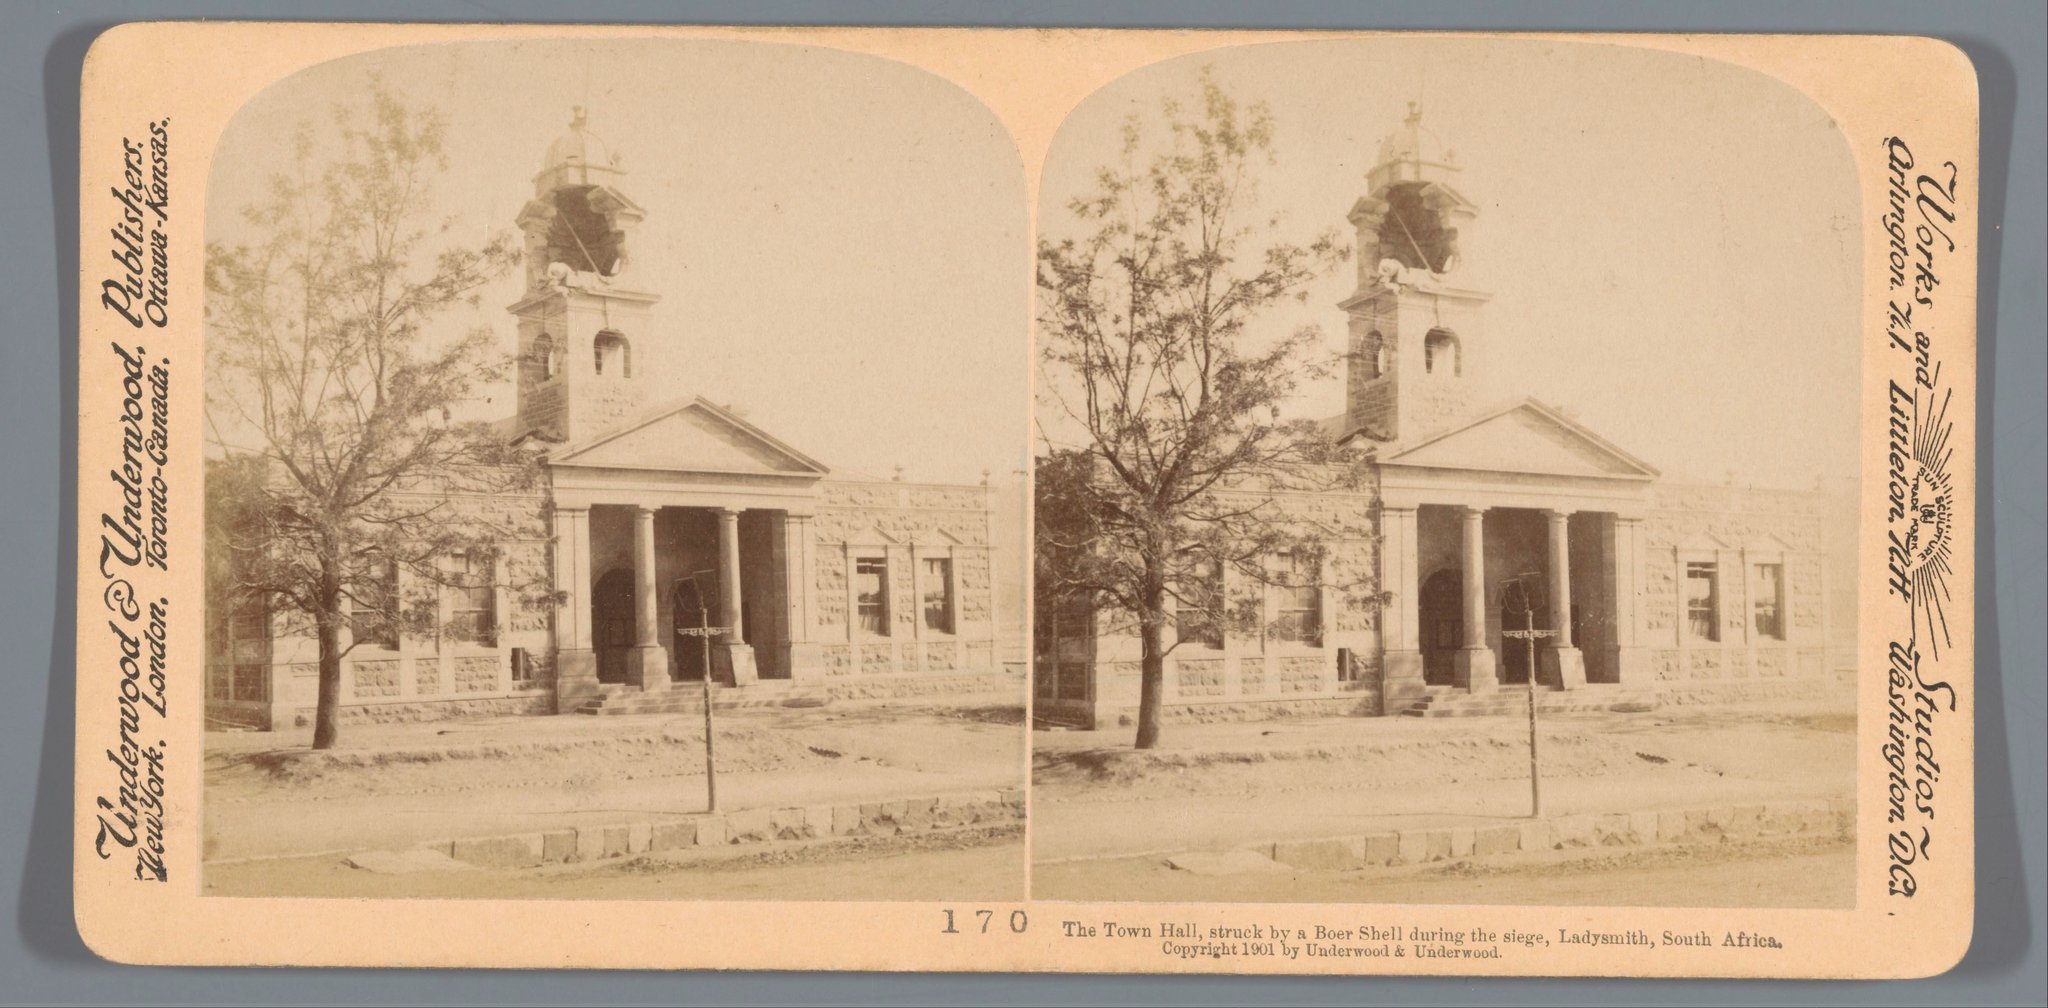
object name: stereograph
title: The Town Hall, struck by a Boer Shell during the siege, Ladysmith, South Africa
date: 1901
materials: cardboard, photographic support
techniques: albumen print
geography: ladysmith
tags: townhall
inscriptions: number: ‘170’, name: ‘Works and Studios Sun Sculpture trade mark Arlington N.J. Littleton N.H. Washington D.C.’